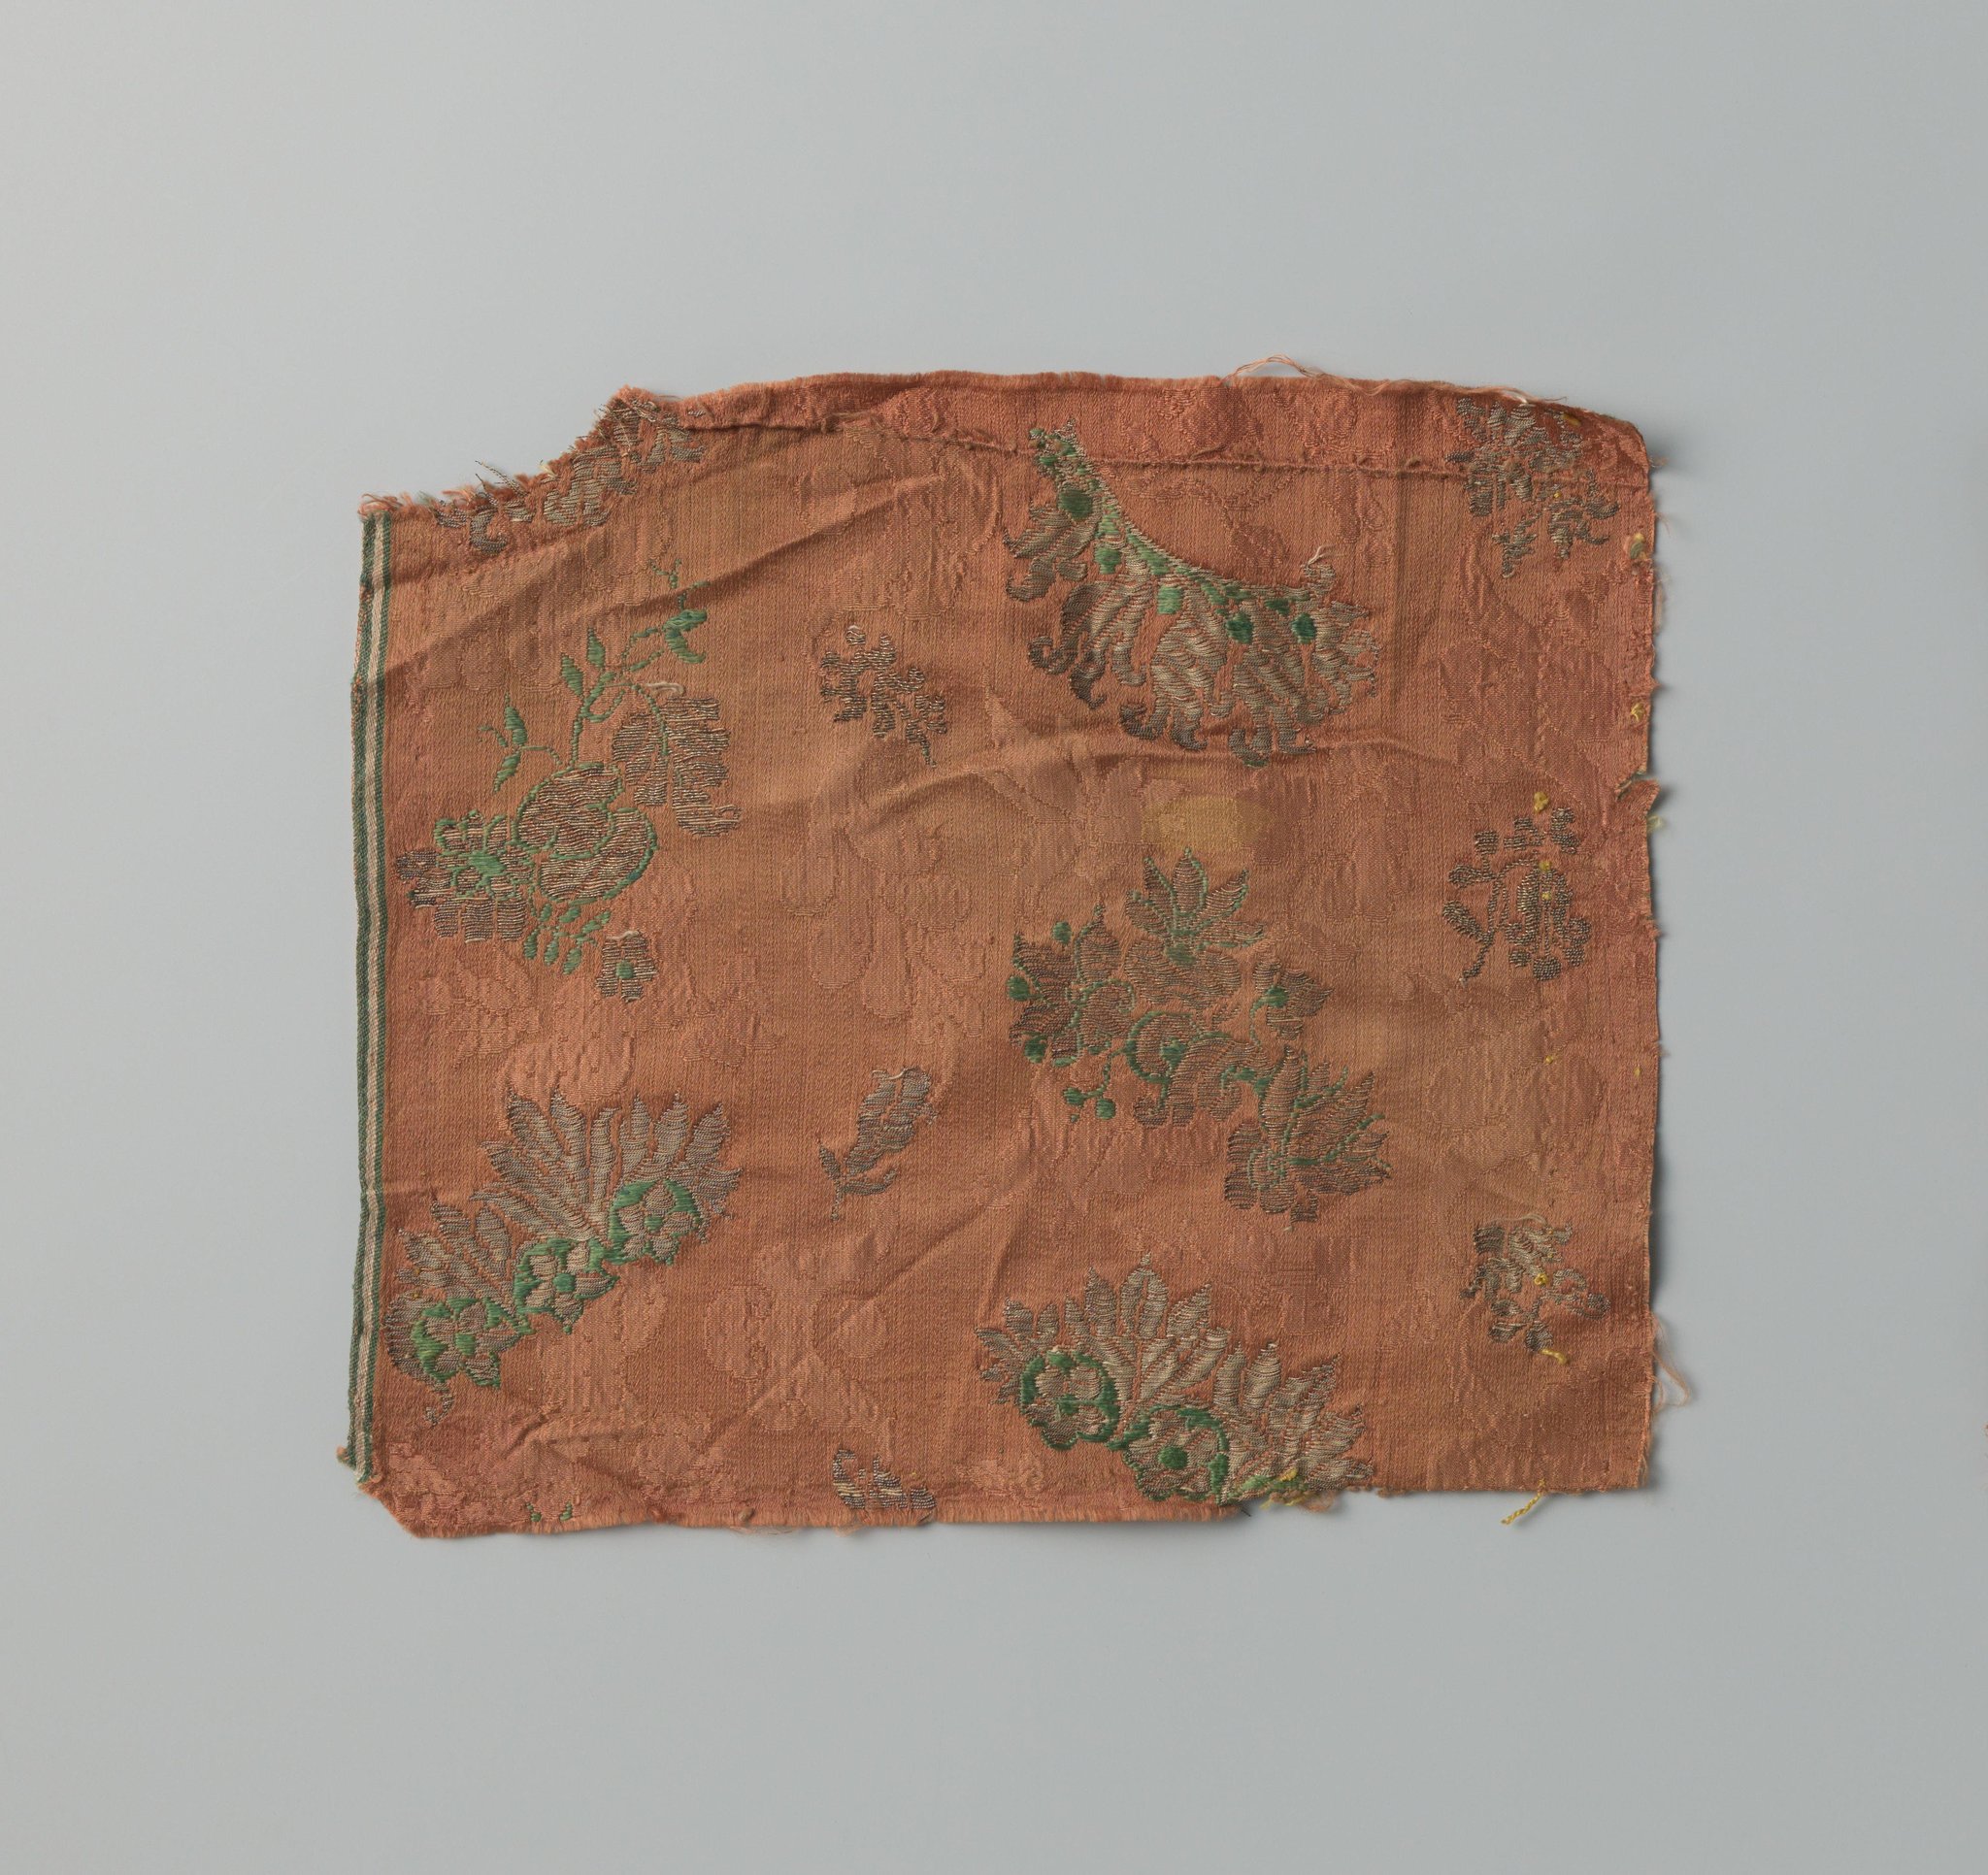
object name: fragment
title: Fragment gebrocheerde zijdebrokaat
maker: Anonymous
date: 1600-1799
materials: metal thread, silk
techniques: brocade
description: Twee fragmenten zijdeweefsel. Een rood-bruine grond heeft een patroon van bloemen en bladeren, waartussen goud- en groenkleurige bloemen en bladeren.